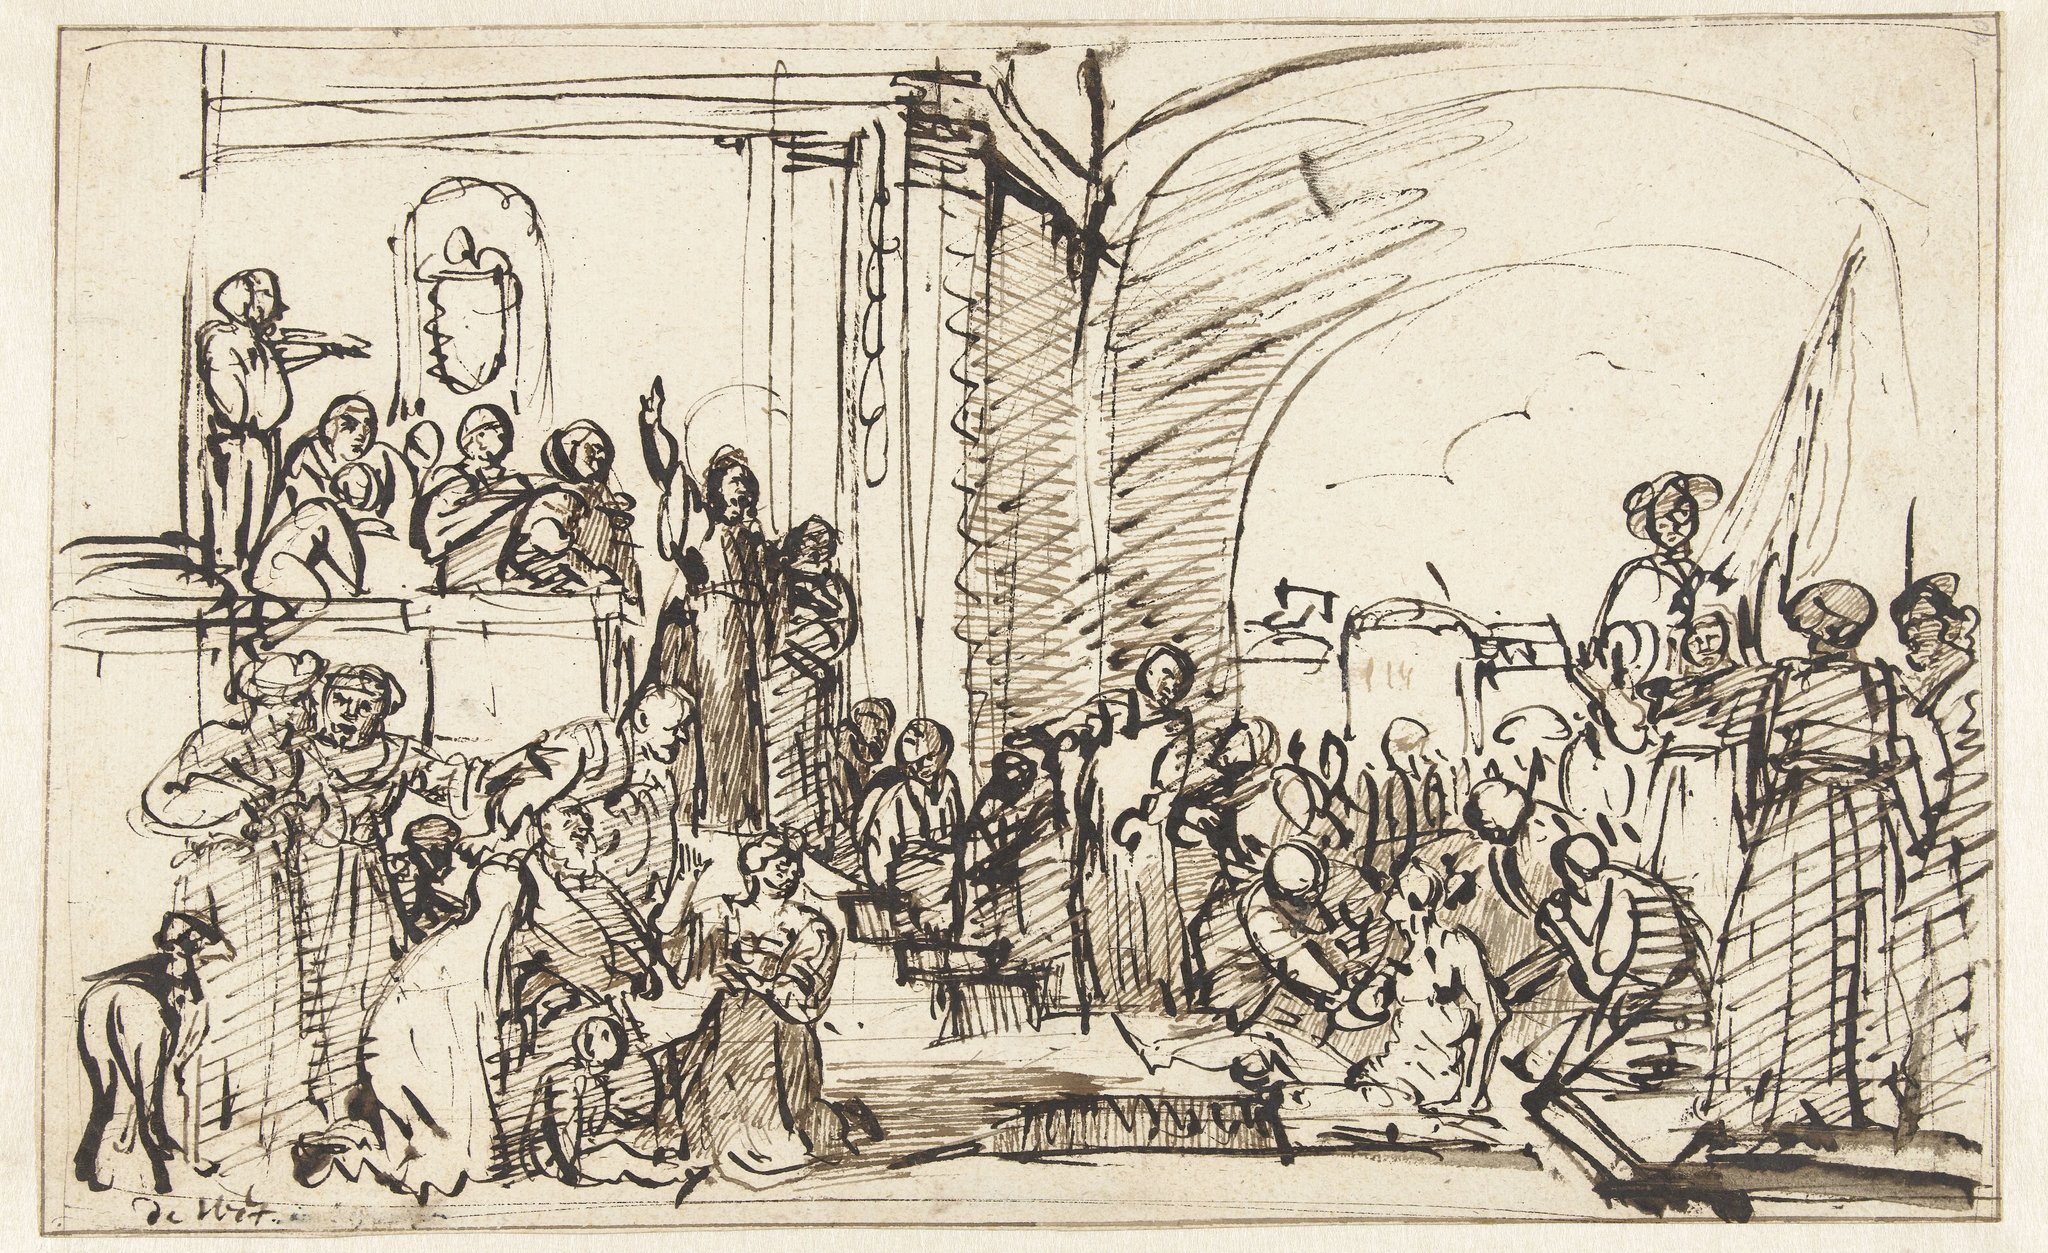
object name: drawing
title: De opwekking van Lazarus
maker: jacob de wet (ii)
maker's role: draughtsman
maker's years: 1640-1697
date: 1650-1697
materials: ink, paper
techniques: pen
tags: the raising of lazarus ('lazarus, come out')